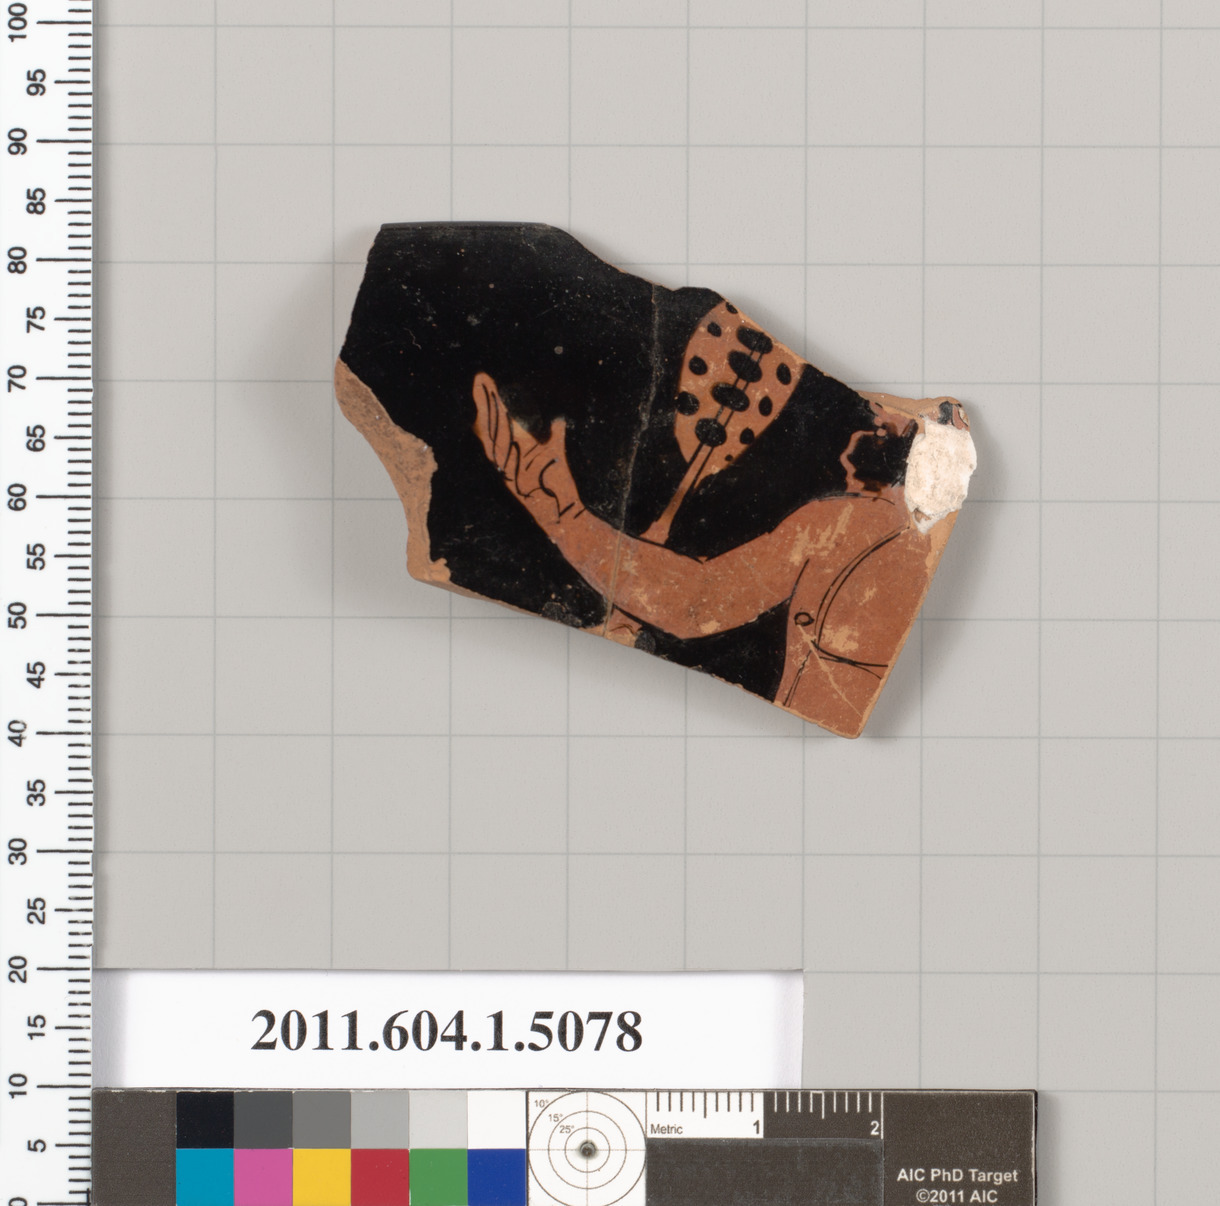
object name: kylix fragment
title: Terracotta rim fragment of a kylix (drinking cup)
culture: greek, attic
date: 467-435 BCE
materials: terracotta